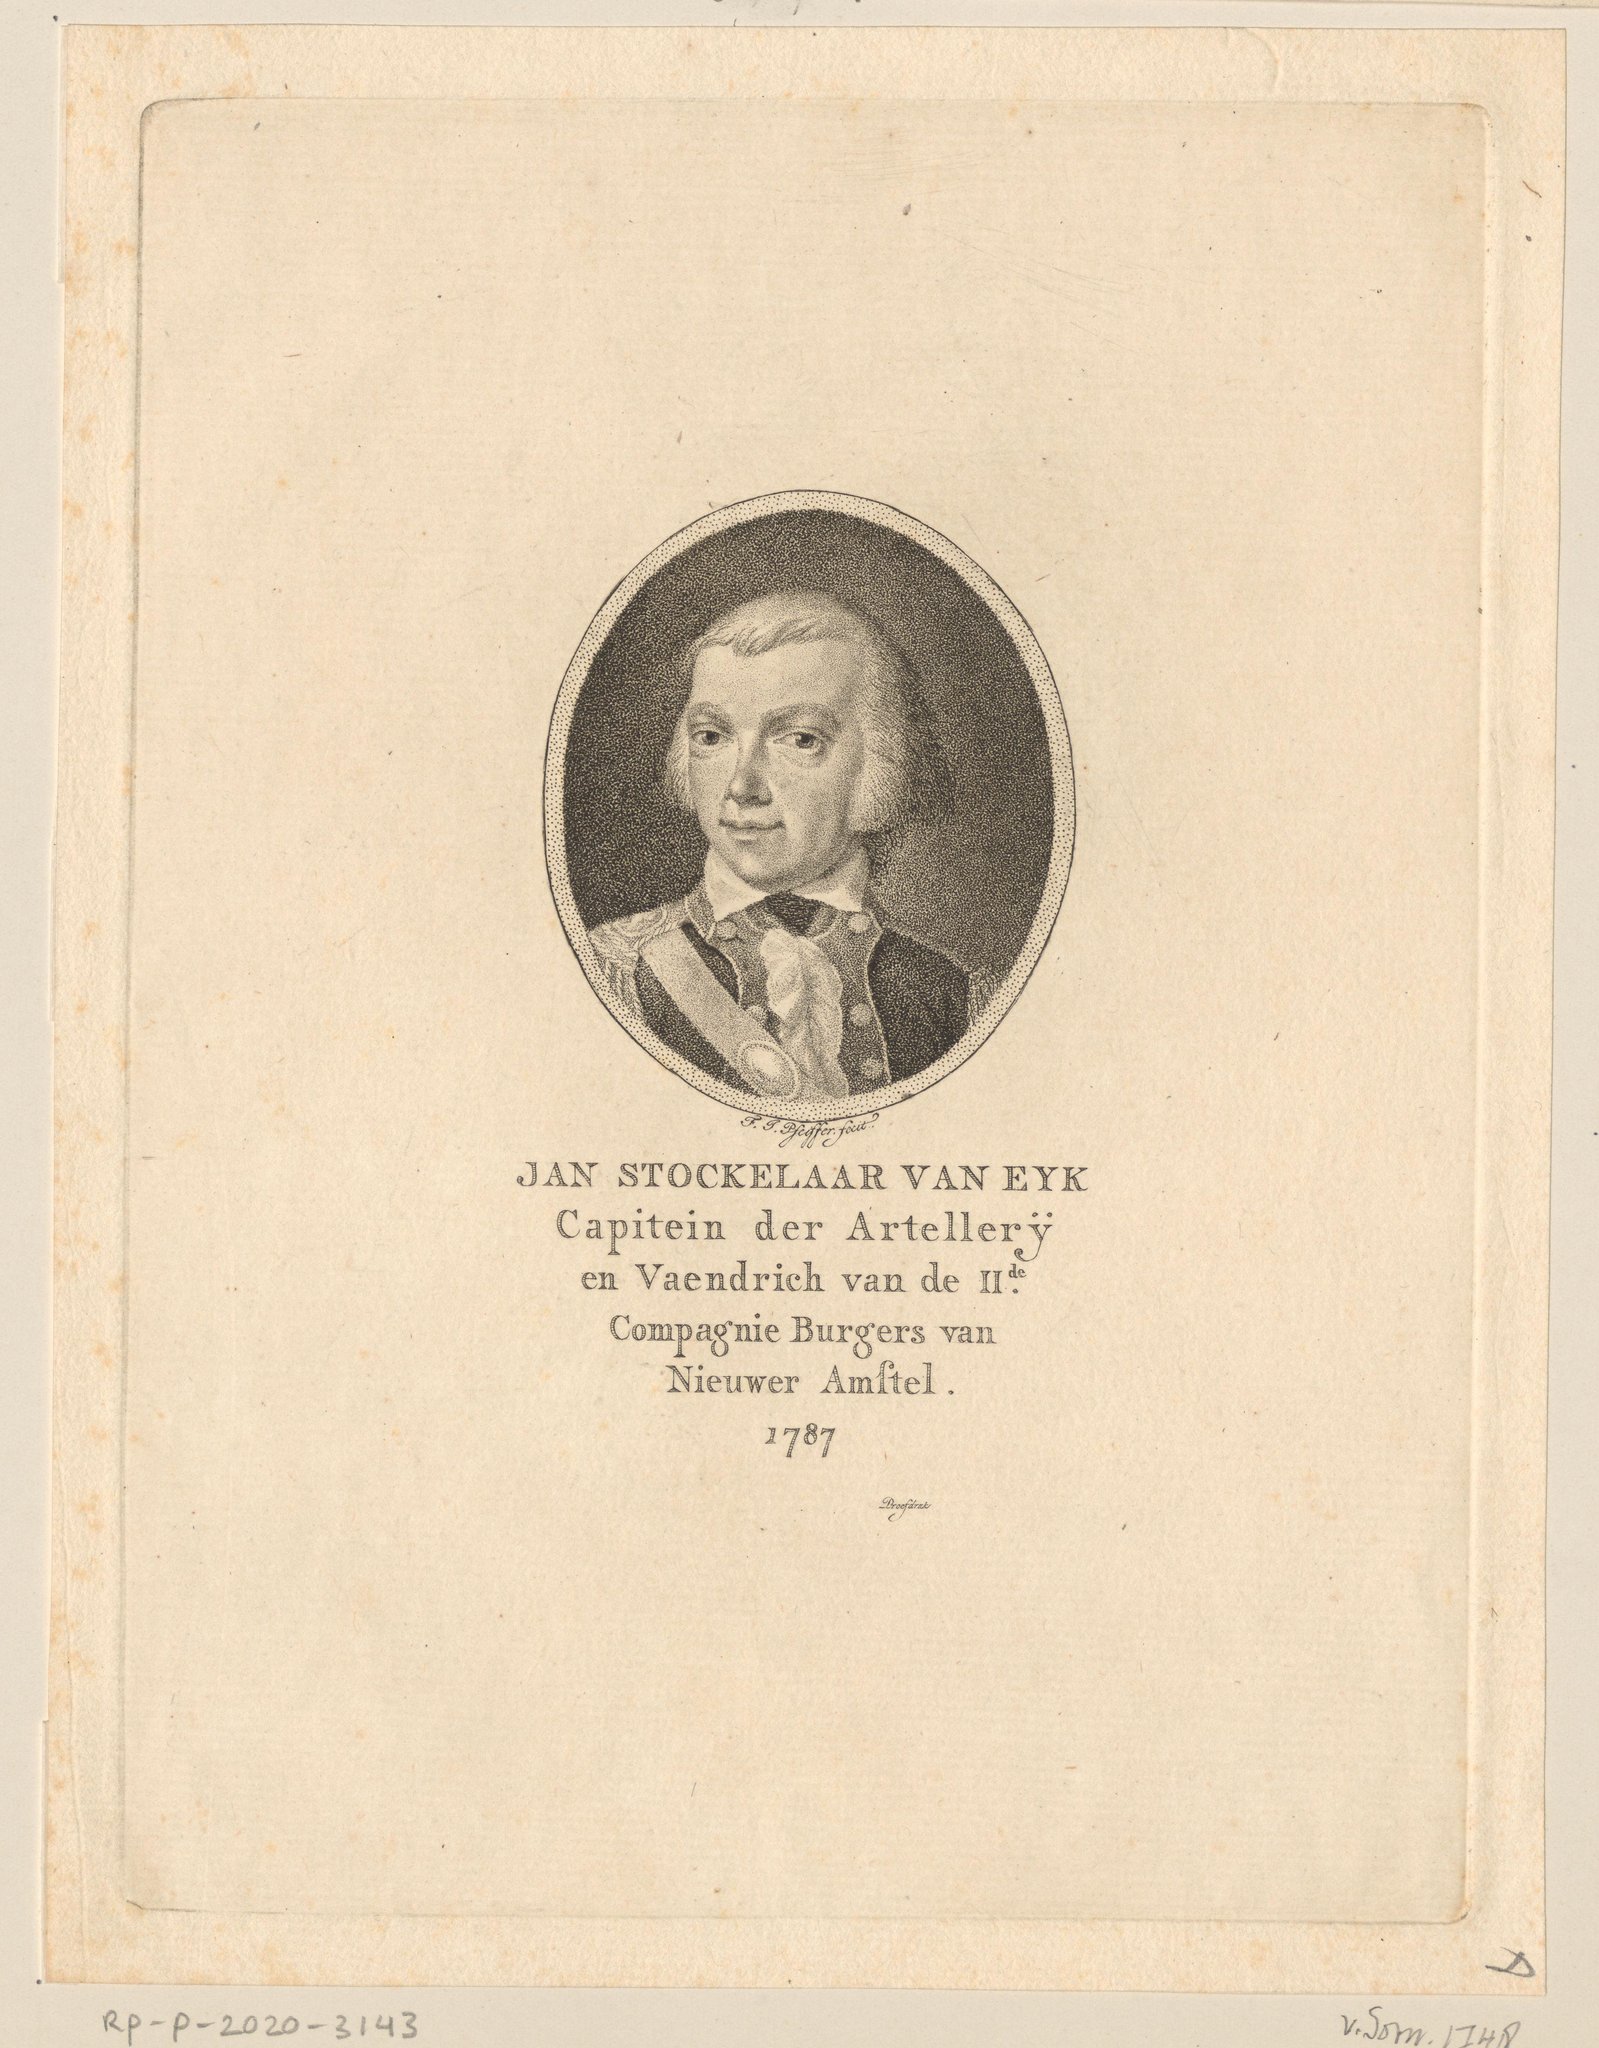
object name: print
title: Portret van Jan Stockelaar van Eyk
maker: françois joseph pfeiffer (i)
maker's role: print maker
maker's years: 1741-1807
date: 1787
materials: paper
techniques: etching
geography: amsterdam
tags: historical persons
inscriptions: date